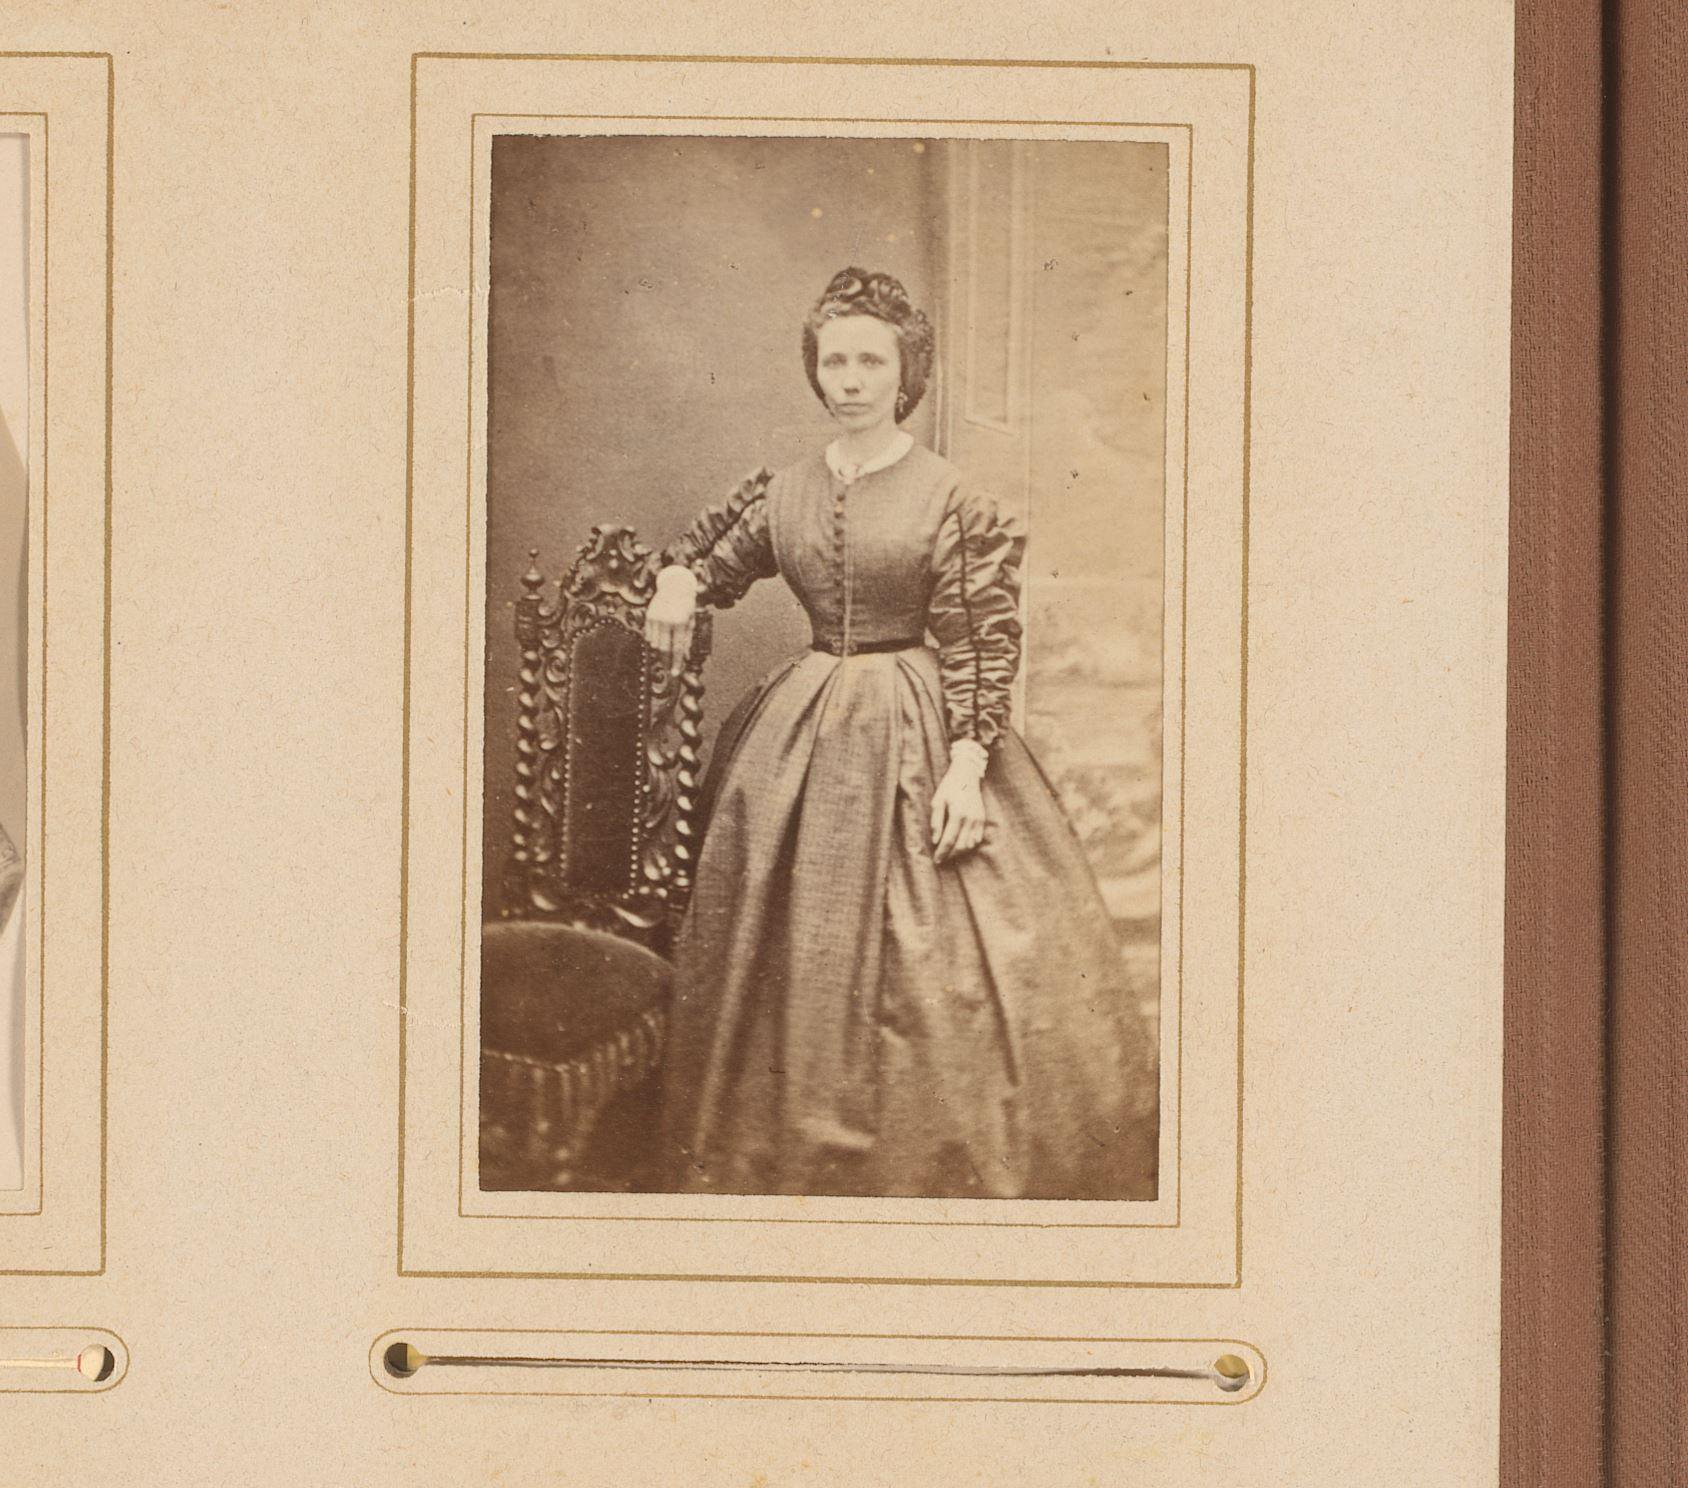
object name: carte de visite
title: Portret van een staande vrouw bij een stoel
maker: albert greiner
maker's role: fotograaf, fotostudio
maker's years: 1833-1890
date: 1861-1887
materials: cardboard, photographic support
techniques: albumen print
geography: amsterdam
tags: historical persons - bb - woman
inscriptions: inscription: ‘A. Greiner/ Photograf/ Amsterdam/ Nieuwendijk L. 89’